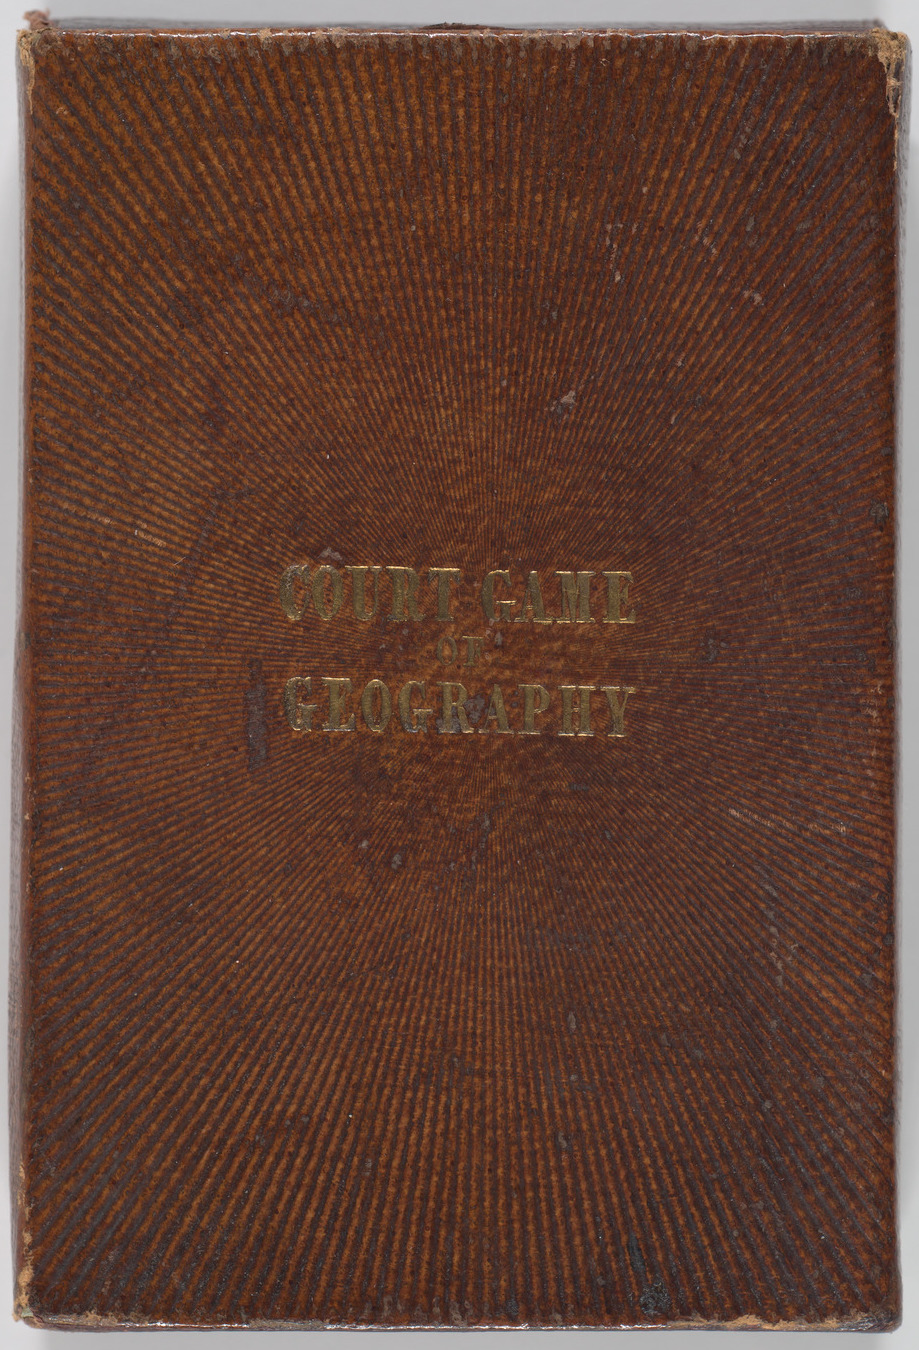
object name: print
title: Court Game of Geography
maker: william and henry rock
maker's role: publisher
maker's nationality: british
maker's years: 1821-1884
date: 1838-1855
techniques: engraving, etching, hand coloring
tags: playing cards